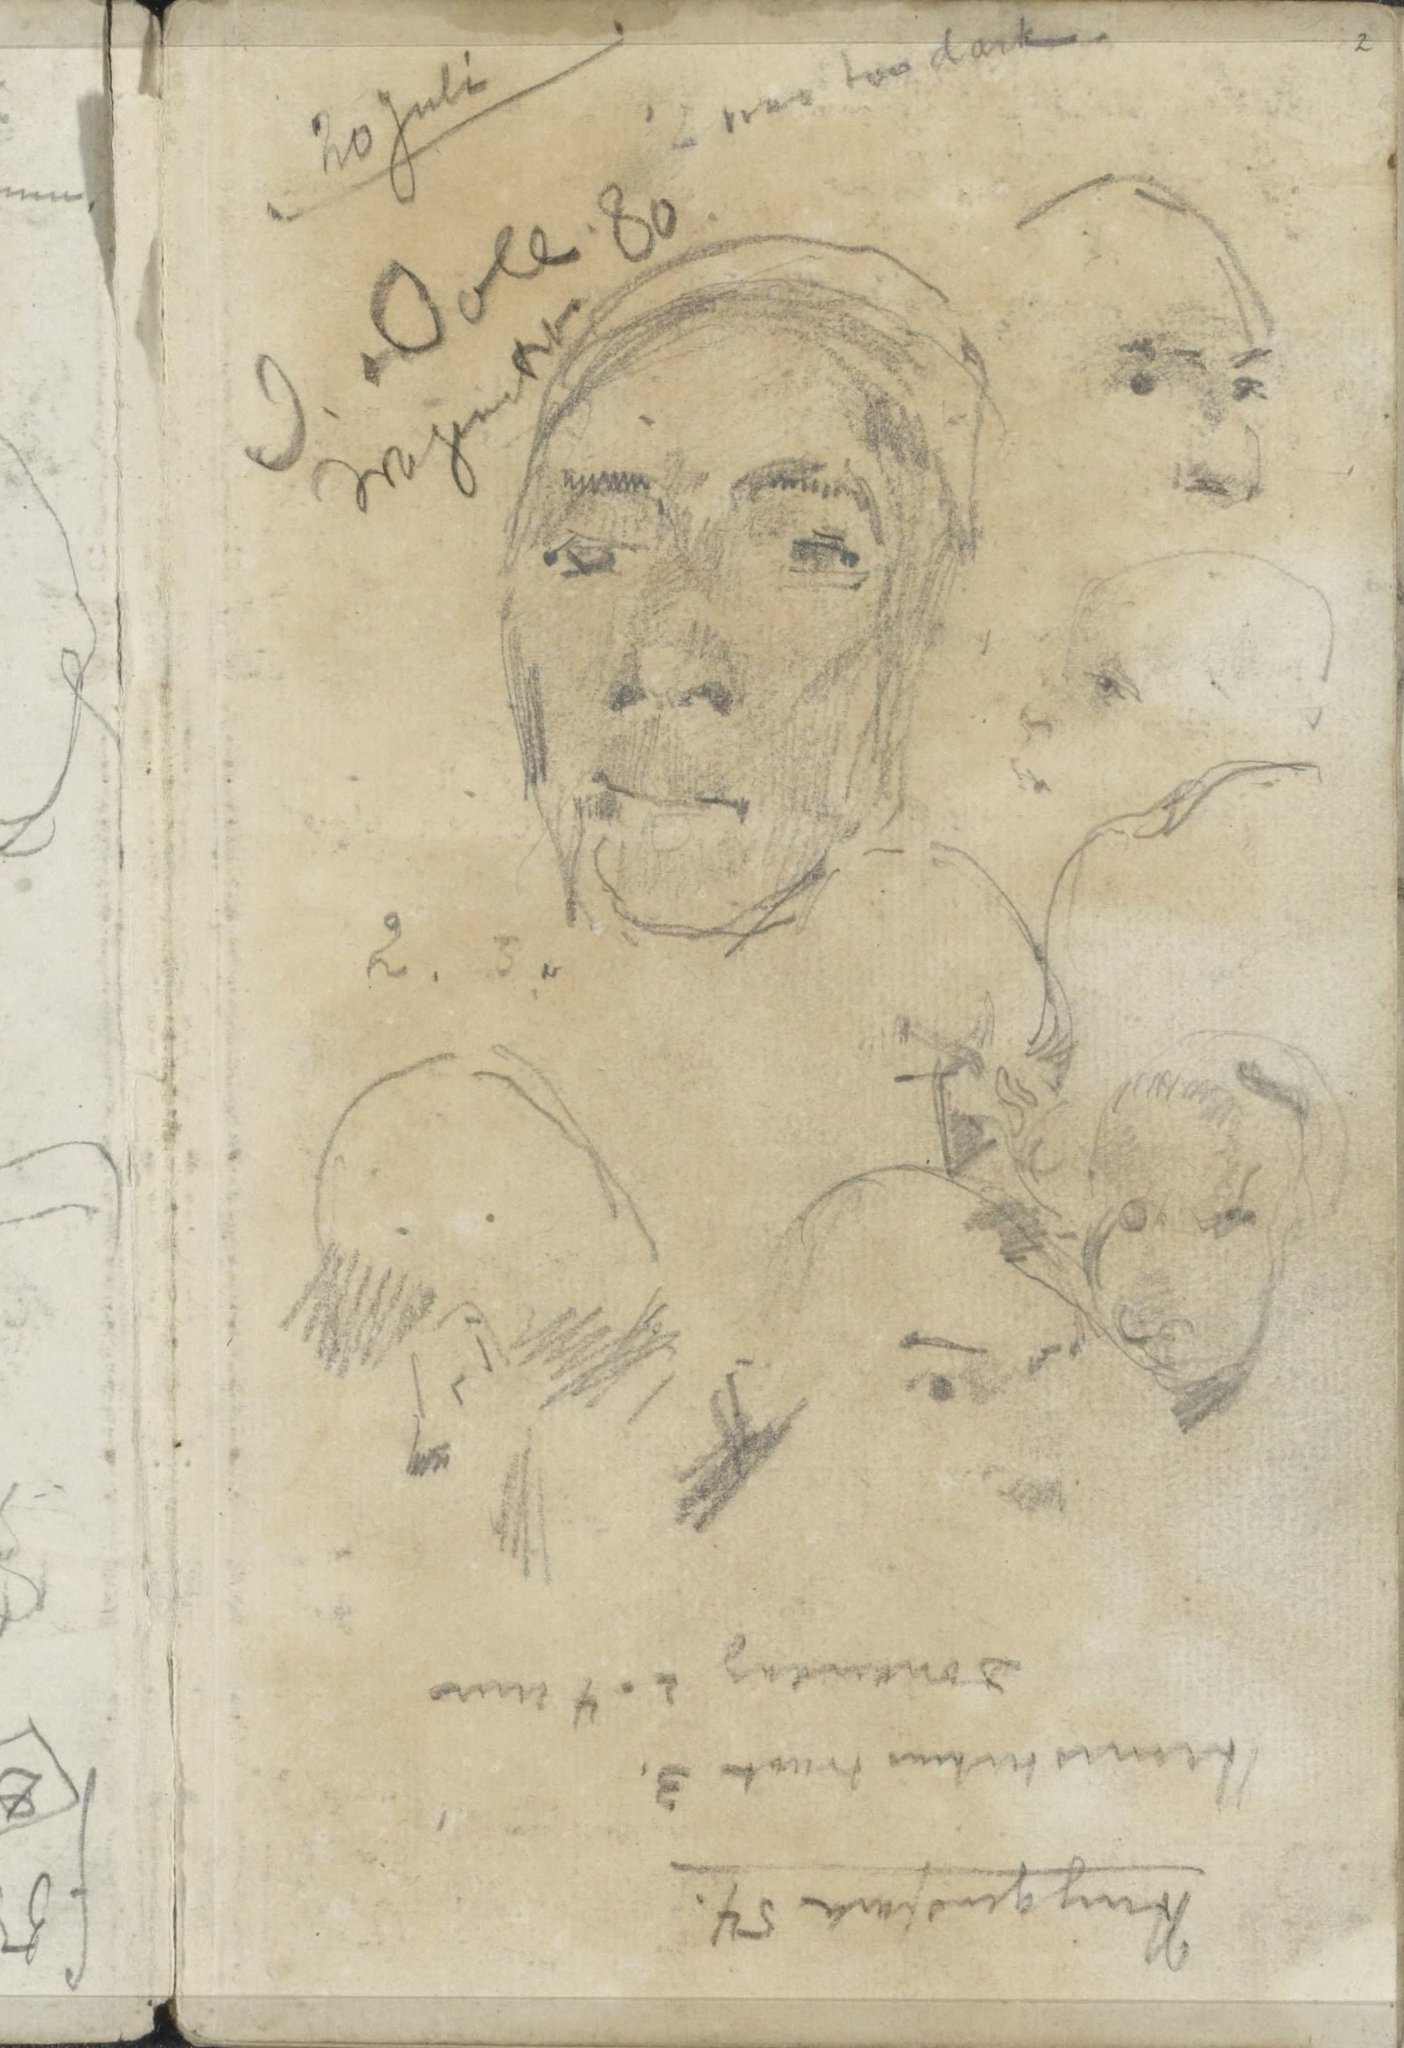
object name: sketchbook leaf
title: Hoofden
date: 1882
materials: paper, pencil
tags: head (human)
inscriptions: annotation: ‘[...] too dark’, name: ‘J. Oole 80 / magenta(?)’, inscription: ‘Huygenspark 54 / Hemsterhuisstraat 3. / Donderdag 2-4 uur’, date: ‘20 juli’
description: Hoofden in verschillende aanzichten. Pagina 2 uit een schetsboek met 31 bladen vervaardigd te Den Haag en Rotterdam.